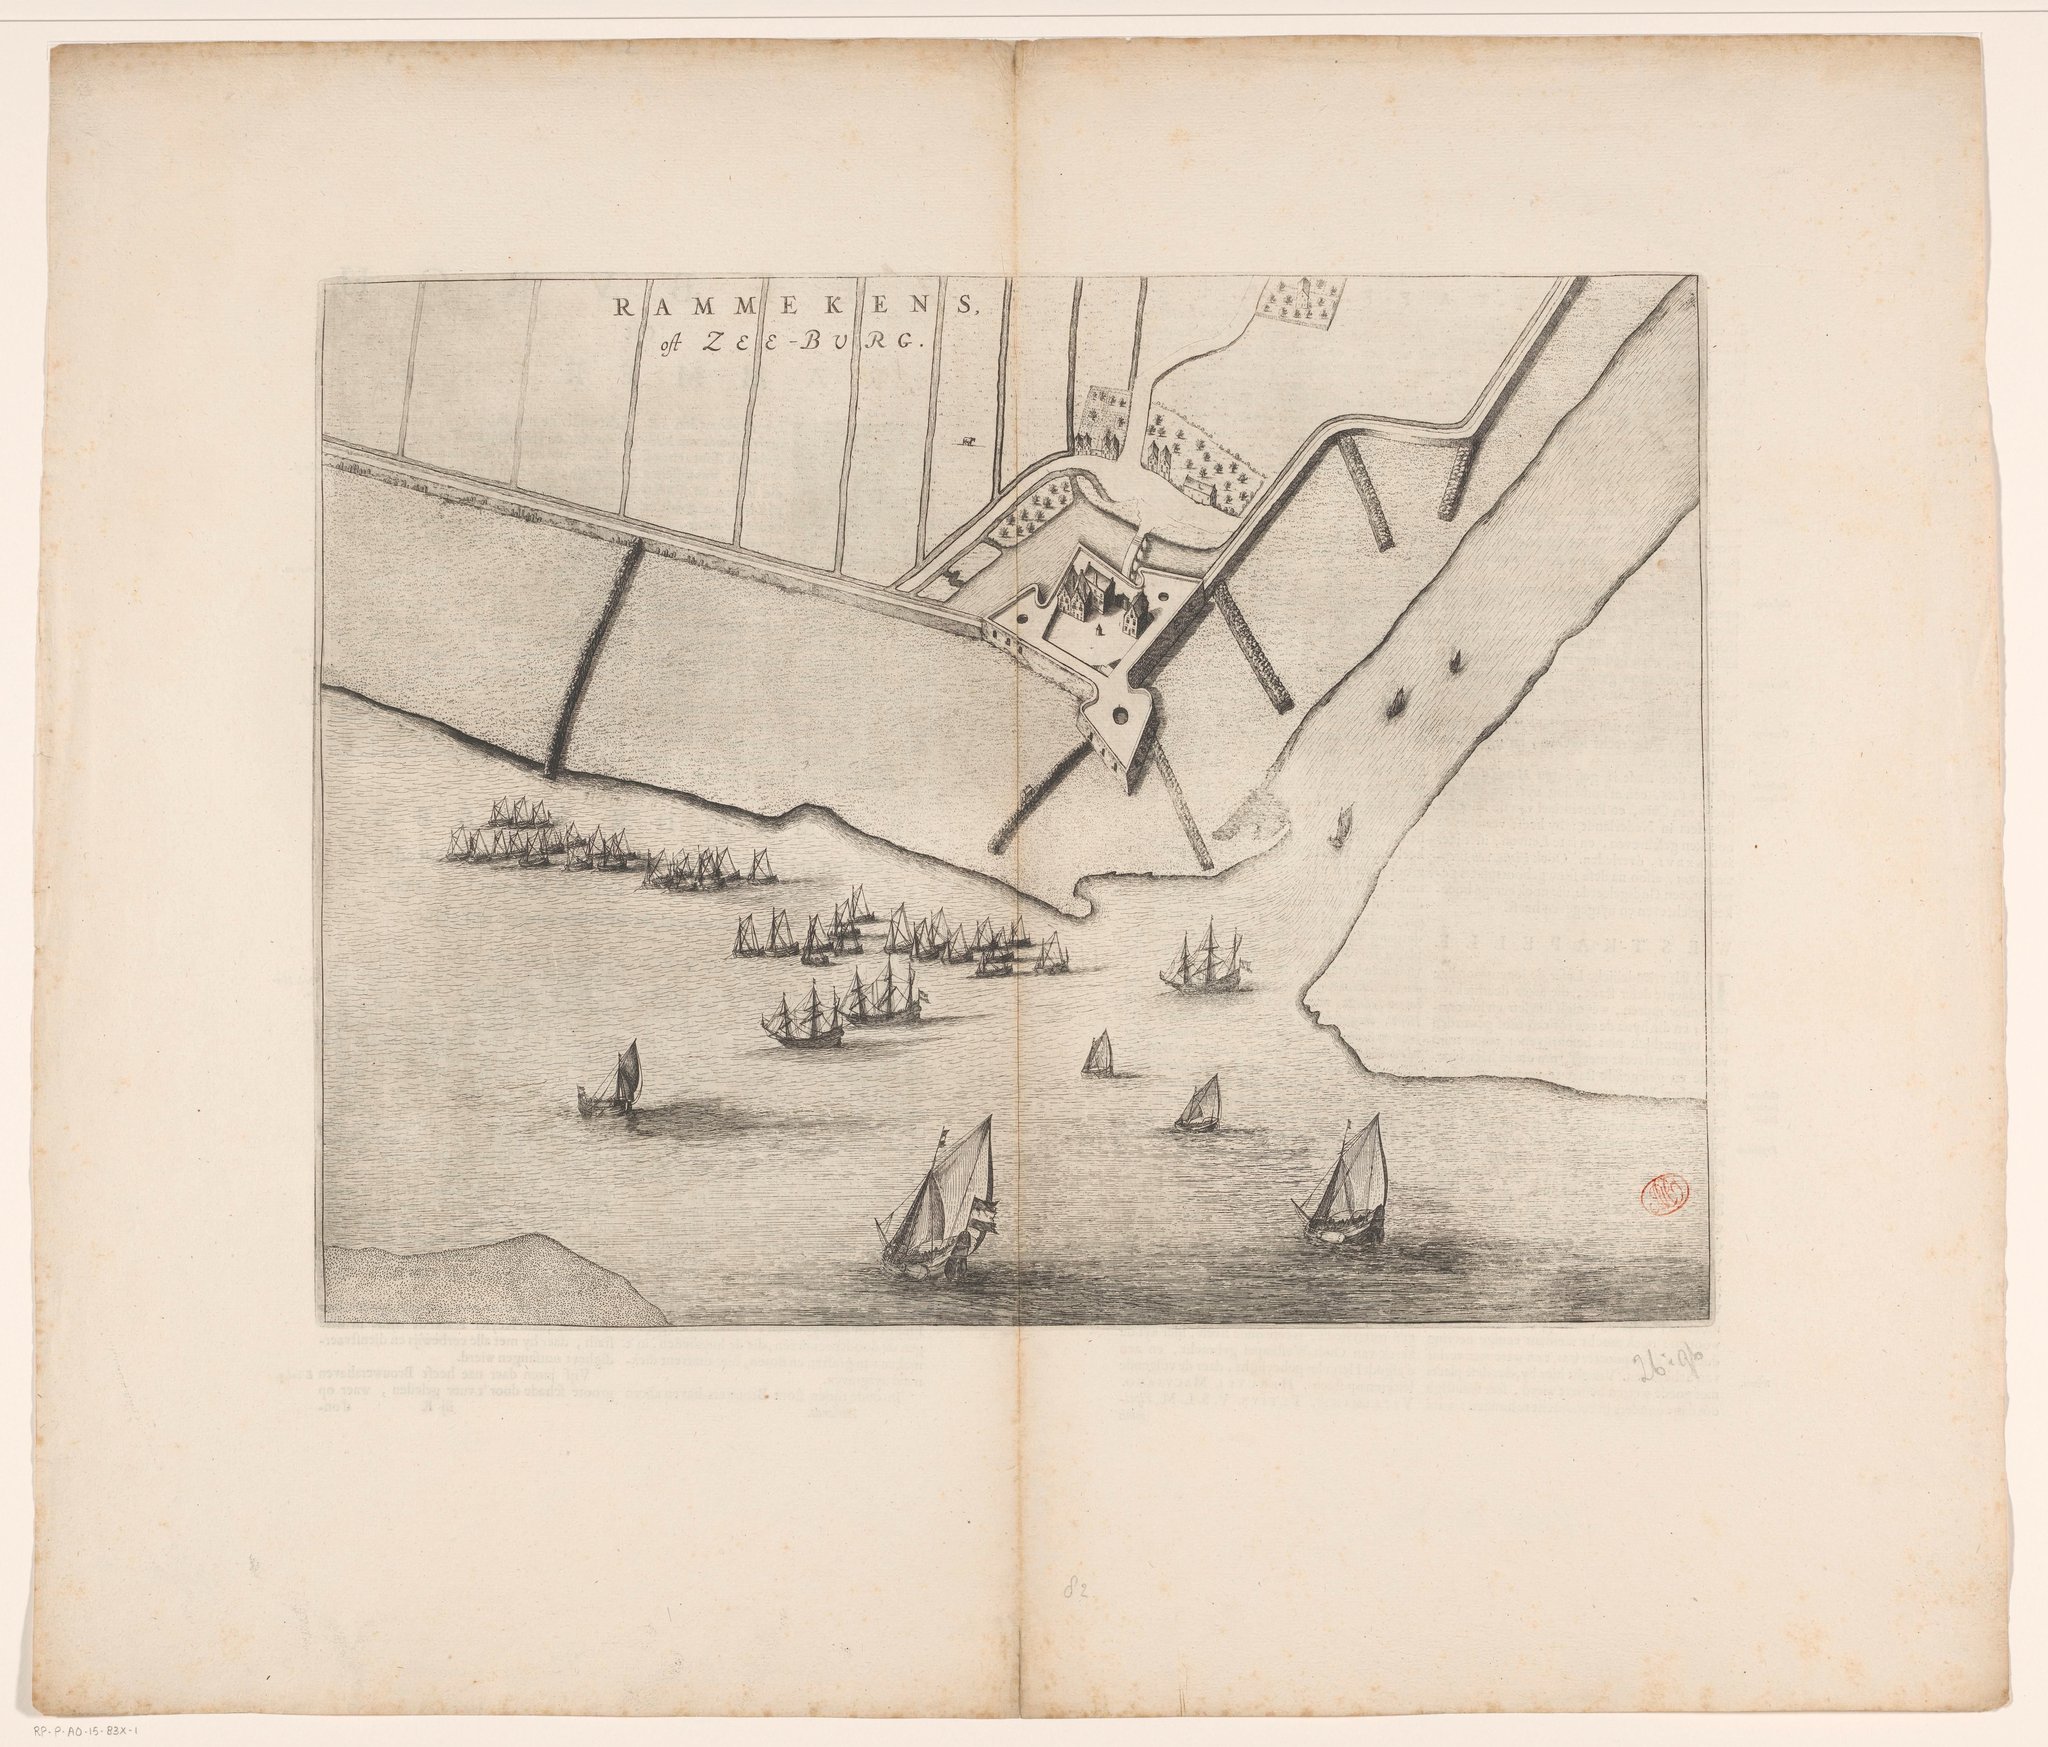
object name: print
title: Rammekens, oft Zee-Burg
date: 1652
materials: paper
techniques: engraving, etching, letterpress printing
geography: amsterdam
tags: fortress, maps, atlases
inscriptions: collector's mark: Lugt 195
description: Prent gebruikt in: Blaeu, Johannes Willemszoon. Toonneel der steden van de Vereenighde Nederlanden. 2 delen. Amsterdam: Johannes Willemszoon Blaeu, 1652, dl. 1.